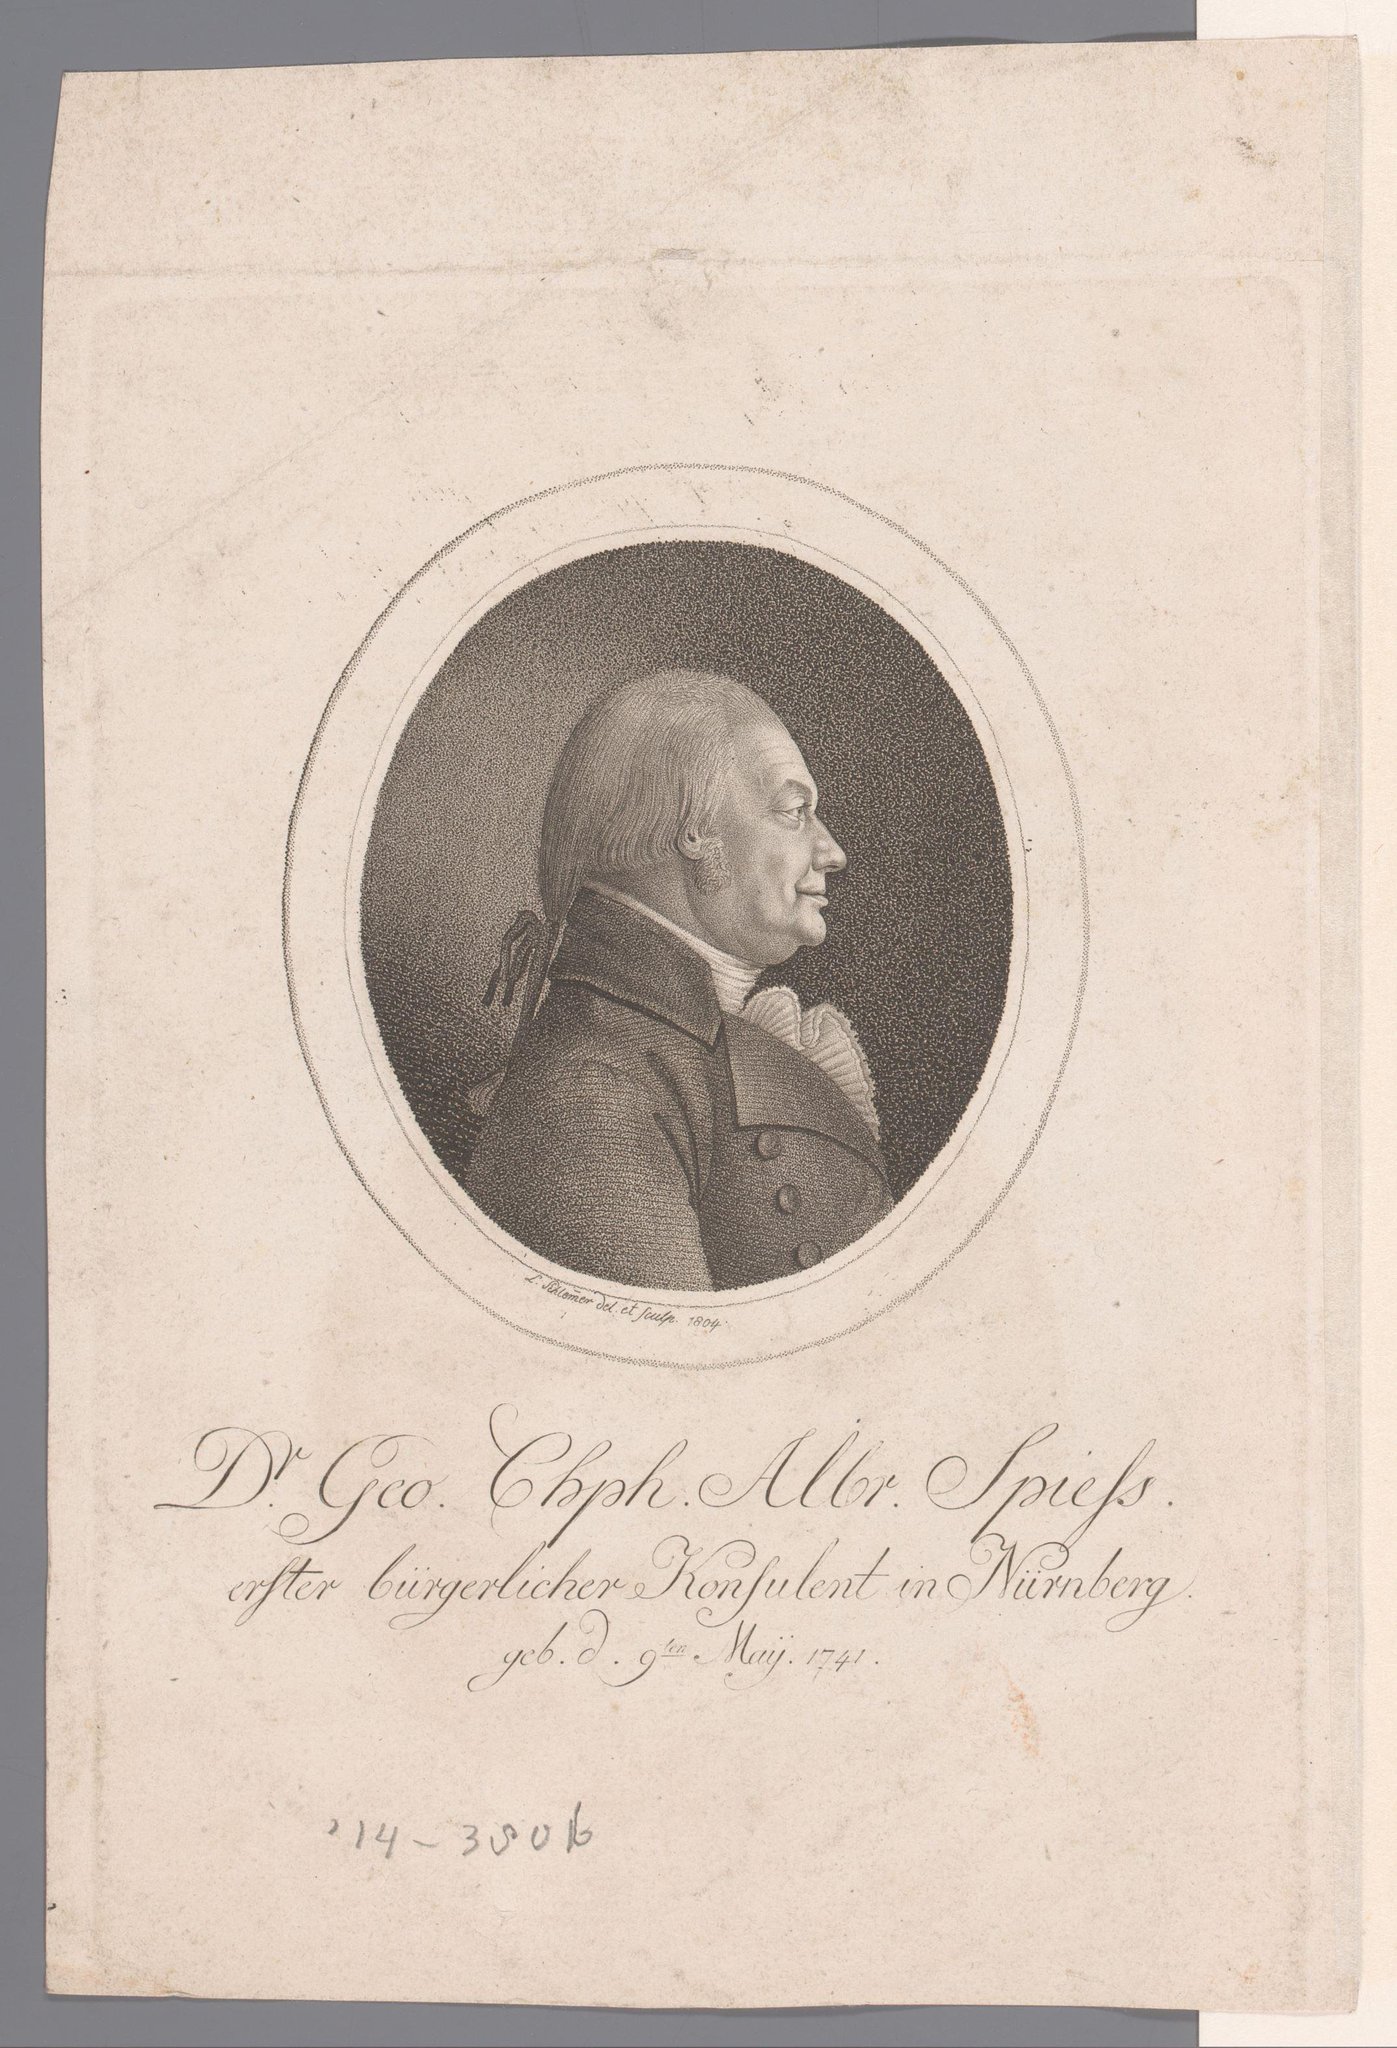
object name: print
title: Portret van Georg Christoph Albrecht Spiess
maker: leonhard schlemmer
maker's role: print maker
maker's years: 1772-1848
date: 1782-1818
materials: paper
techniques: stippling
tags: historical persons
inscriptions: collector's mark: Lugt 2228